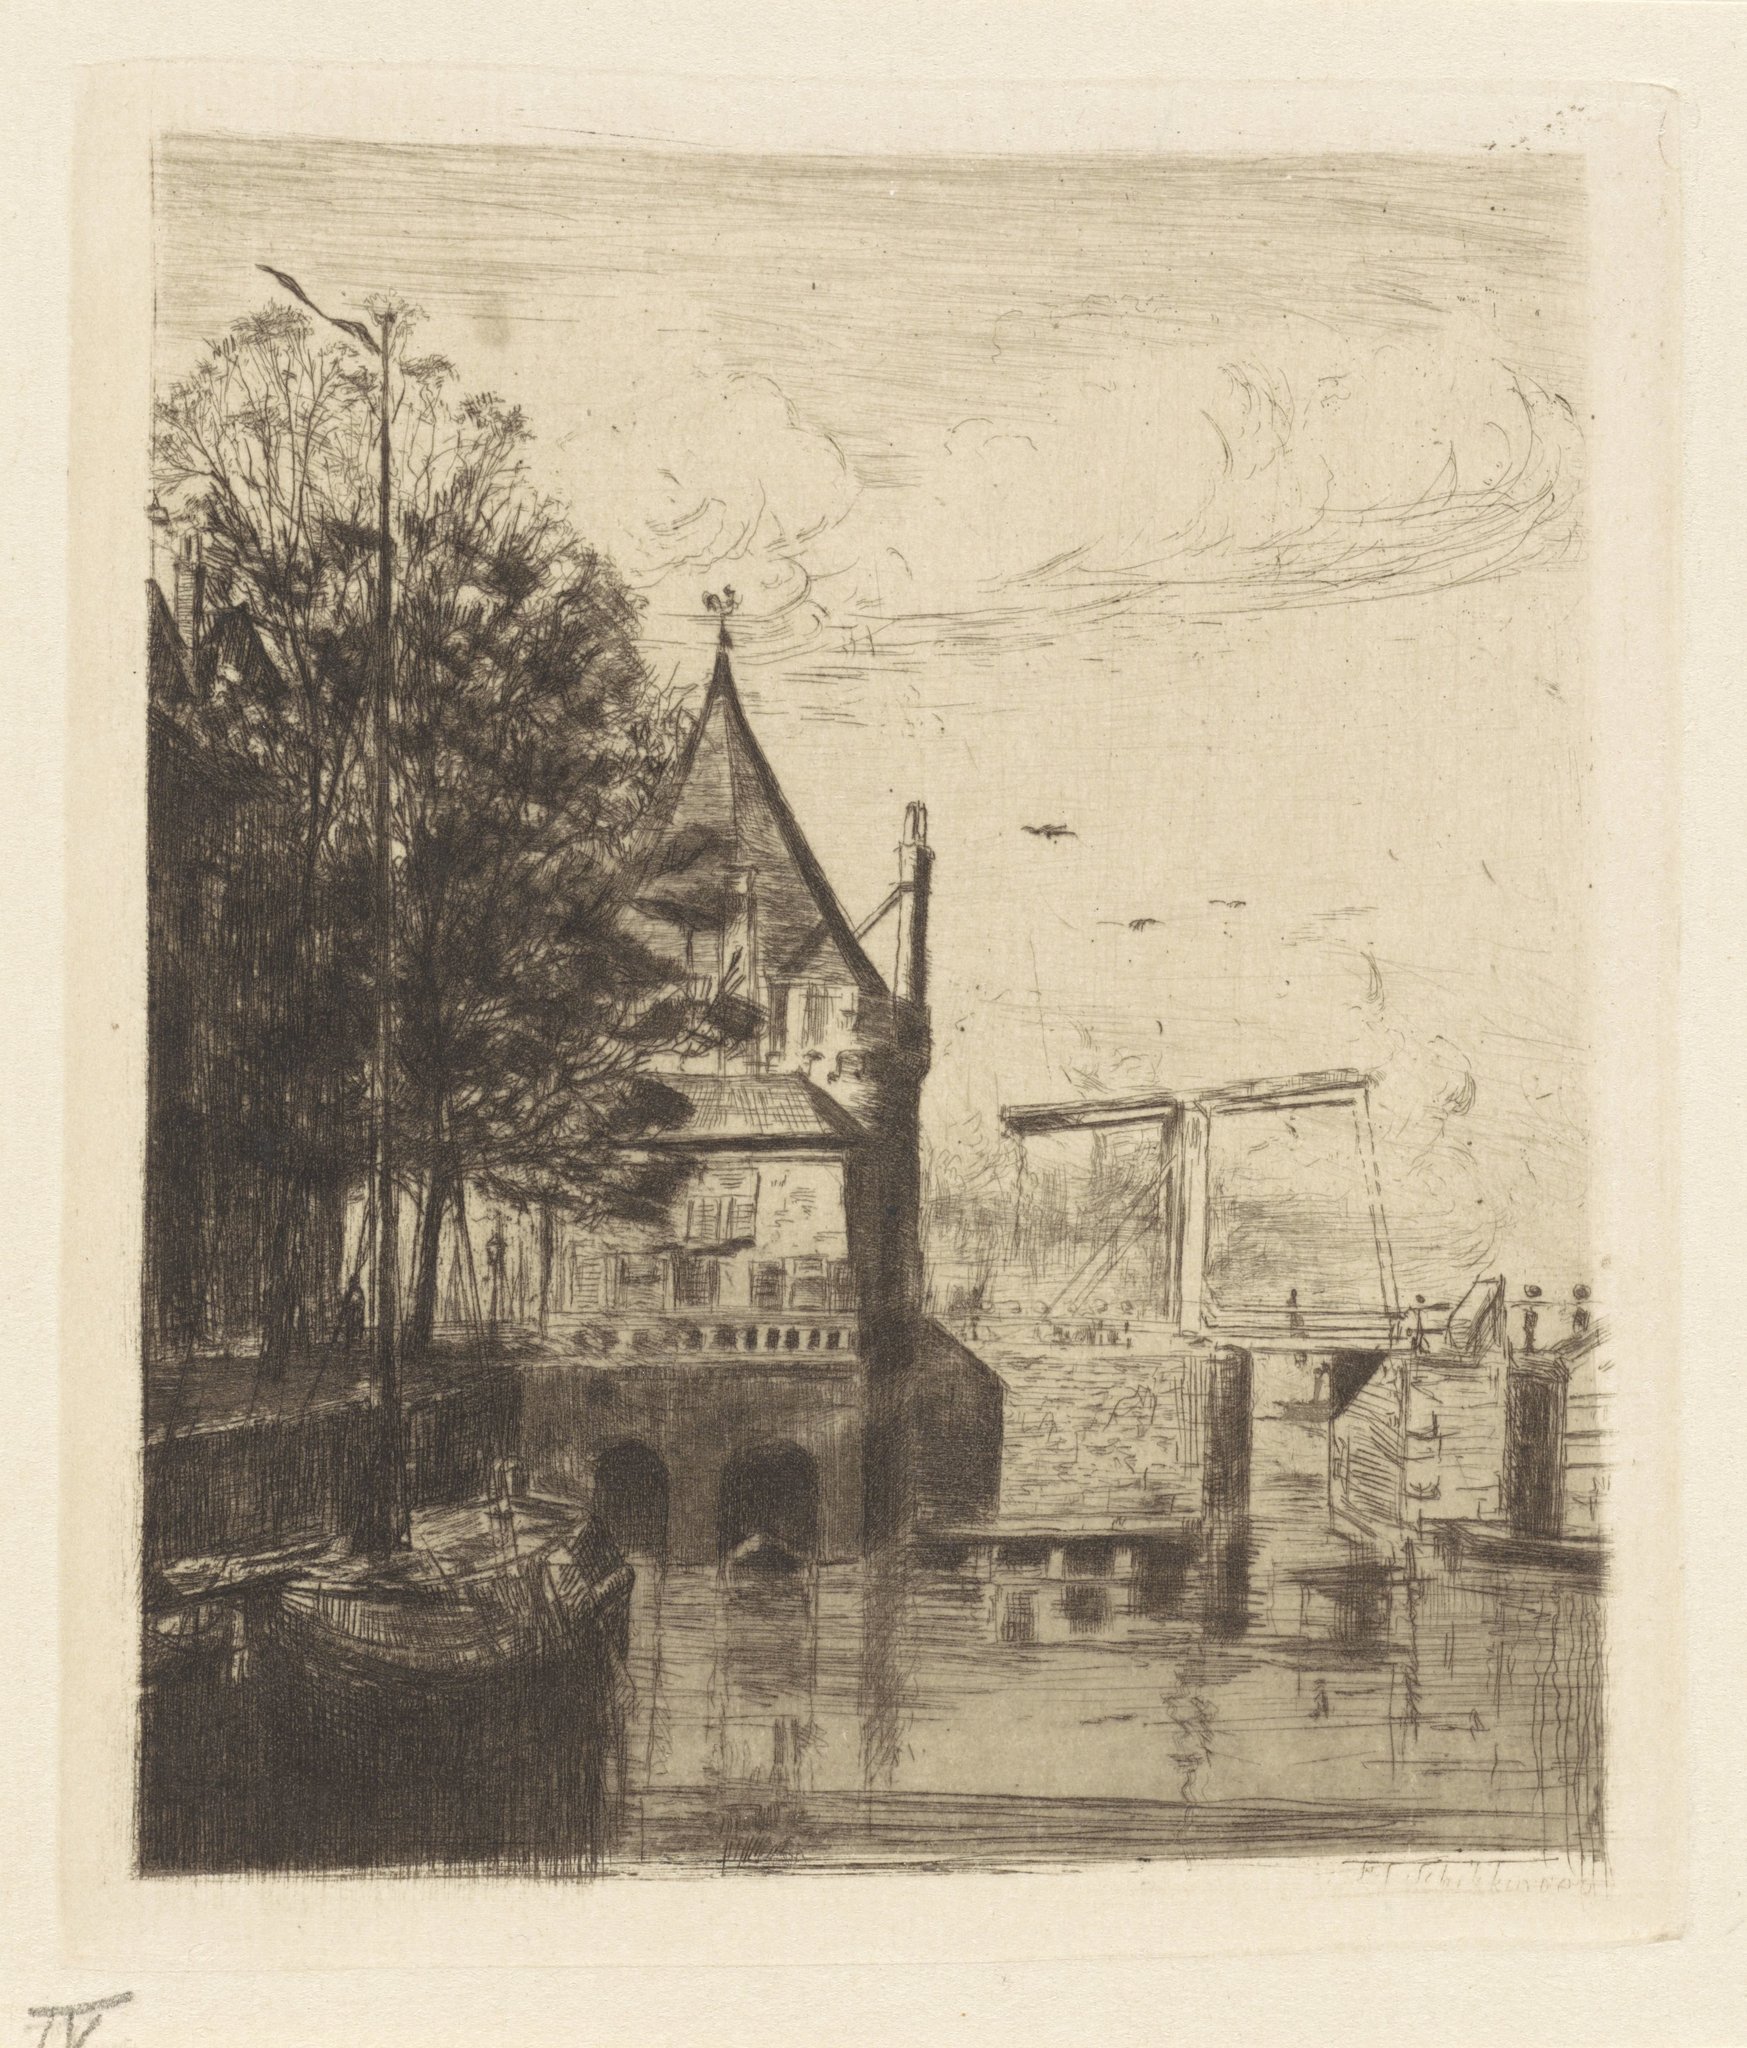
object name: print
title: Gezicht op de Schreierstoren te Amsterdam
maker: frans schikkinger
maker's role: print maker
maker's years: 1838-1902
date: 1848-1902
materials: paper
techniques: drypoint, etching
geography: amsterdam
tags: tower, clock tower ~ monumental adornment, canals, waters (in city)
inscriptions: collector's mark: Lugt 2228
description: Gezicht op de Schreierstoren vanaf het water van de Geldersekade.